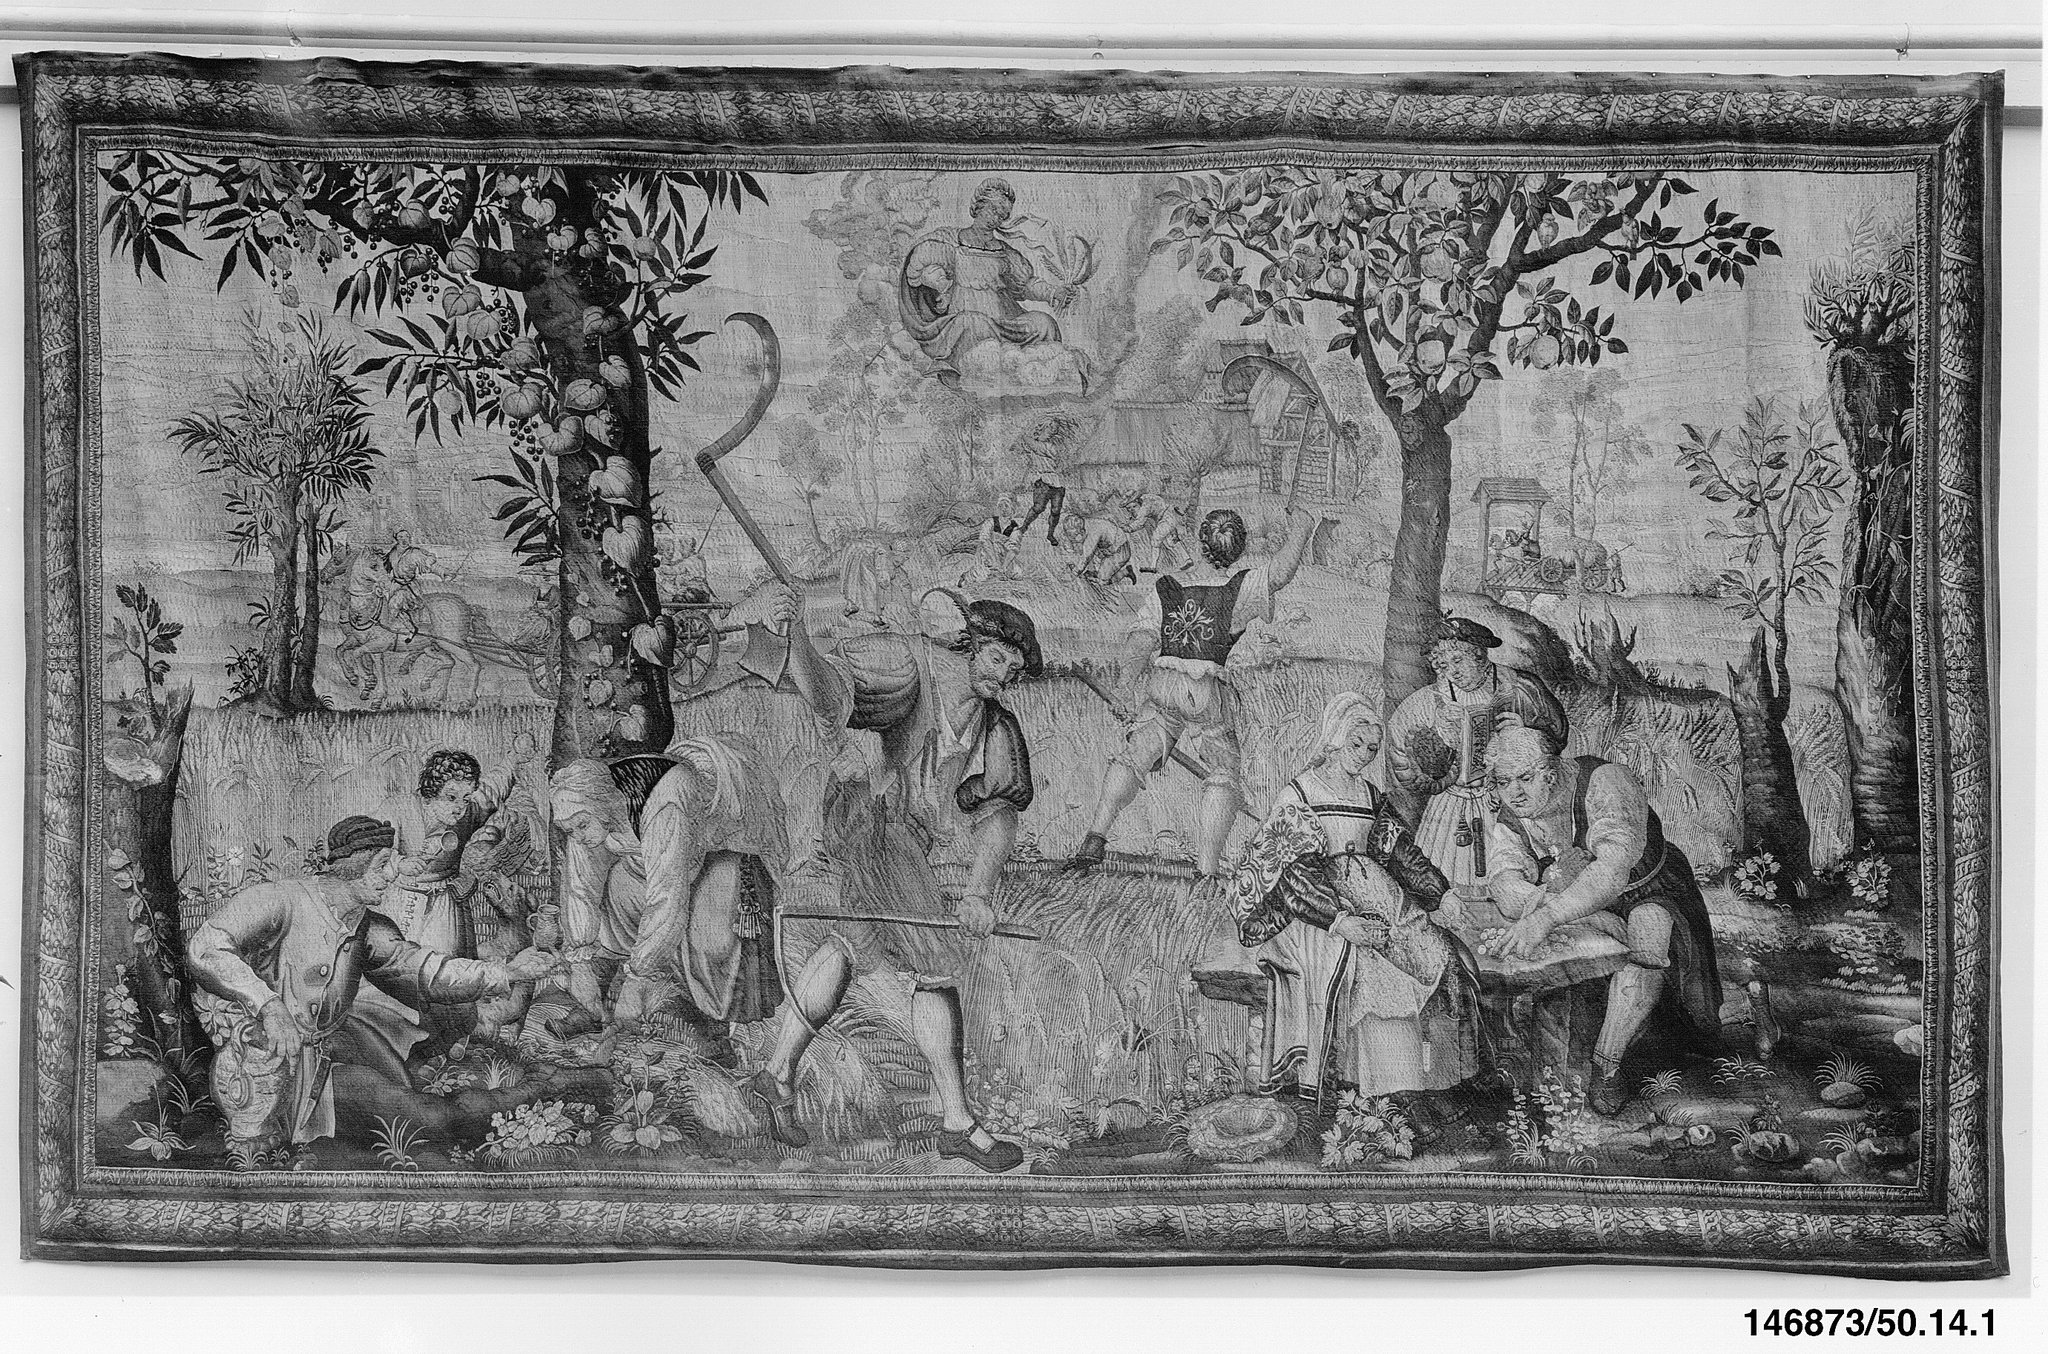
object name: tapestry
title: Summer from a set of The Seasons of Lucas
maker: master of the months of lucas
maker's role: designer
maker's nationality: netherlandish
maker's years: 1535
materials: silk, wool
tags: men,women,trees,summer,working